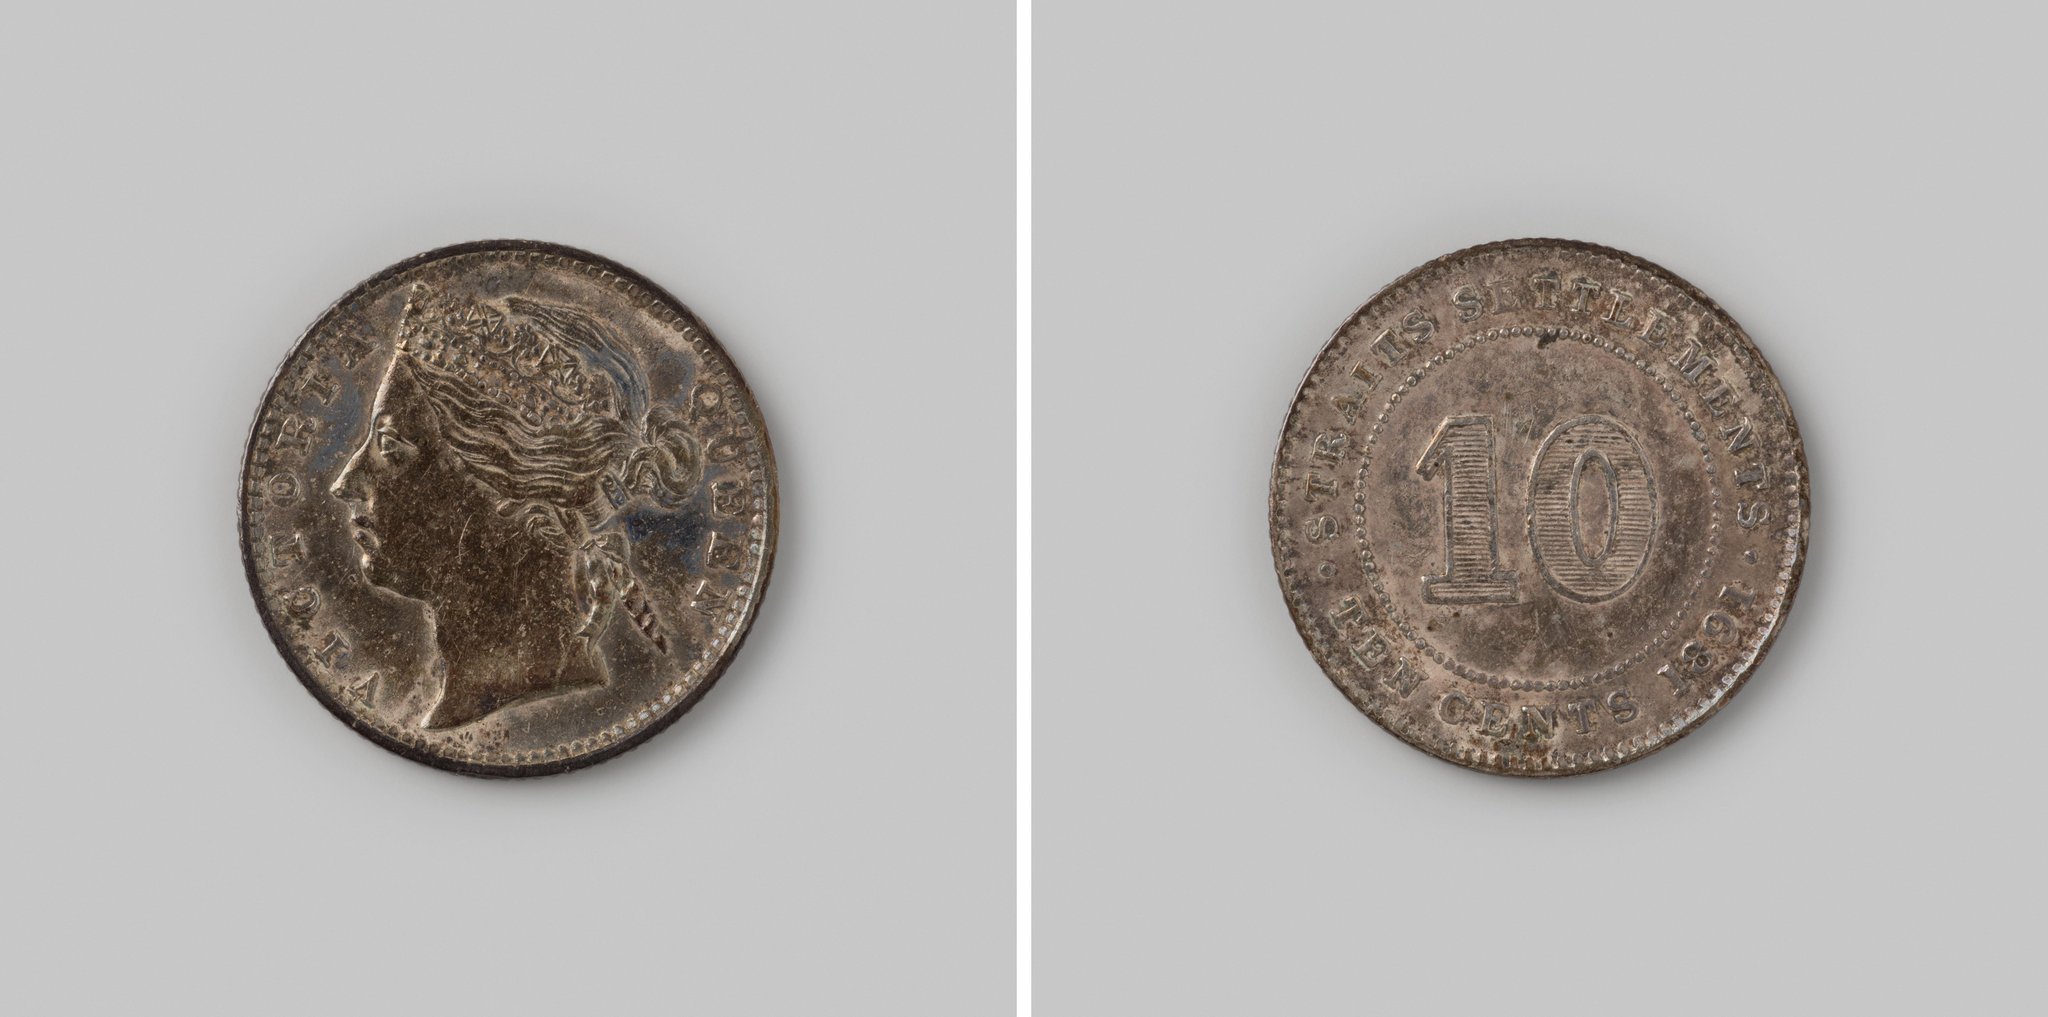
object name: coin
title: Straits Settlements, koningin Victoria, 10 cents, 1891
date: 1891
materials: silver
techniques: striking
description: Zilveren munt. Voorzijde: gekroond hoofd van koningin Victoria naar links. Keerzijde: binnen parelcirkel waarde-aanduiding: 10. In omschrift onderaan waarde-aanduiding: ten cents met rechts daarvan jaartal. Kartelrand.